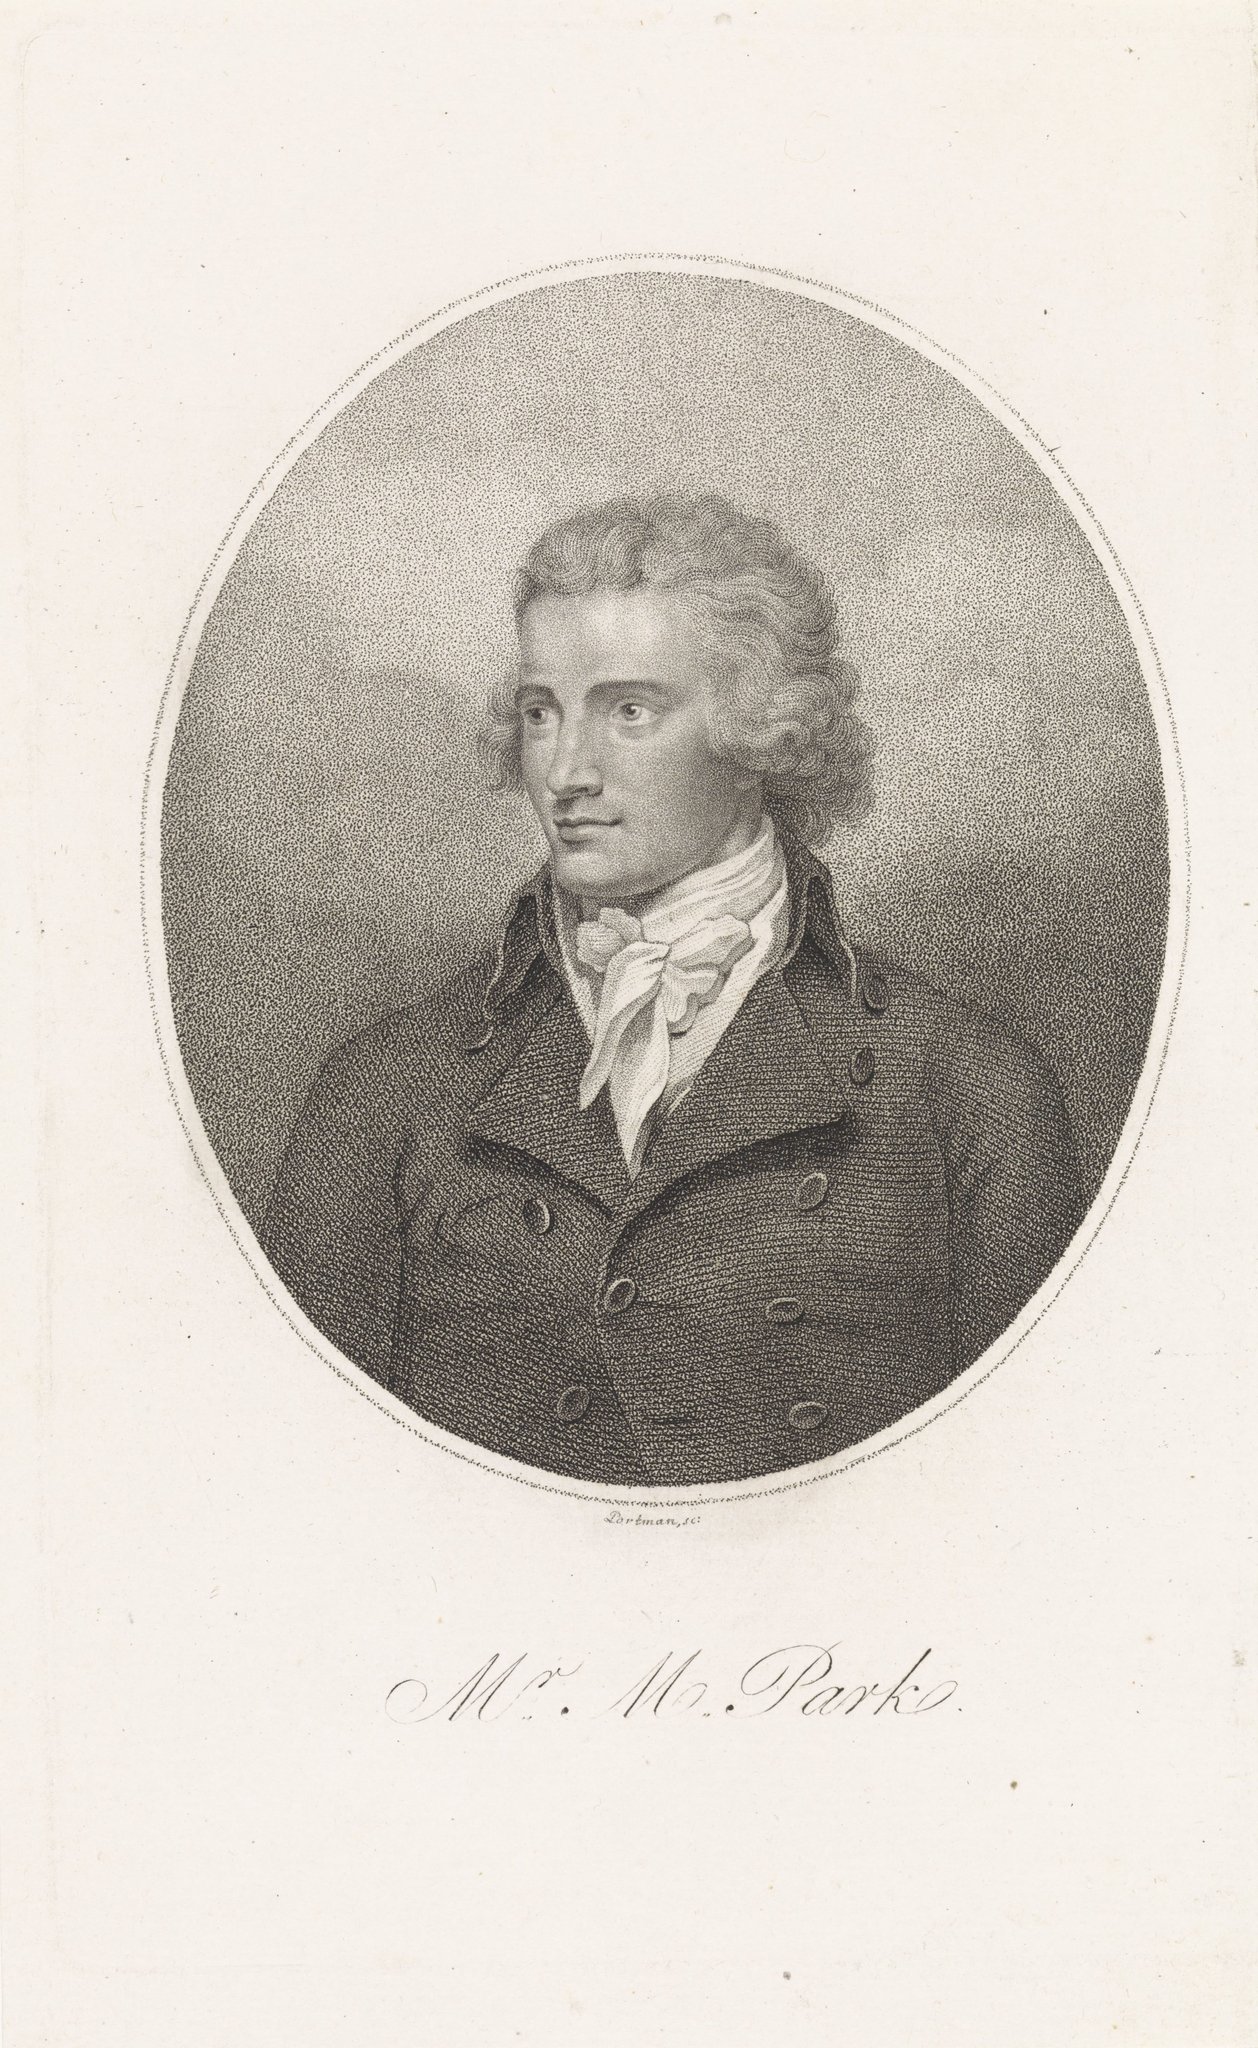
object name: print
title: Portret van de Schotse arts Mungo Park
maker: ludwig gottlieb portman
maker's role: print maker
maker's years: 1772-1828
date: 1787-1828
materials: paper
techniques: stippled etching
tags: foulshiels, bussa, arts, ontdekkingsreiziger, mungo park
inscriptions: collector's mark: Lugt 2228